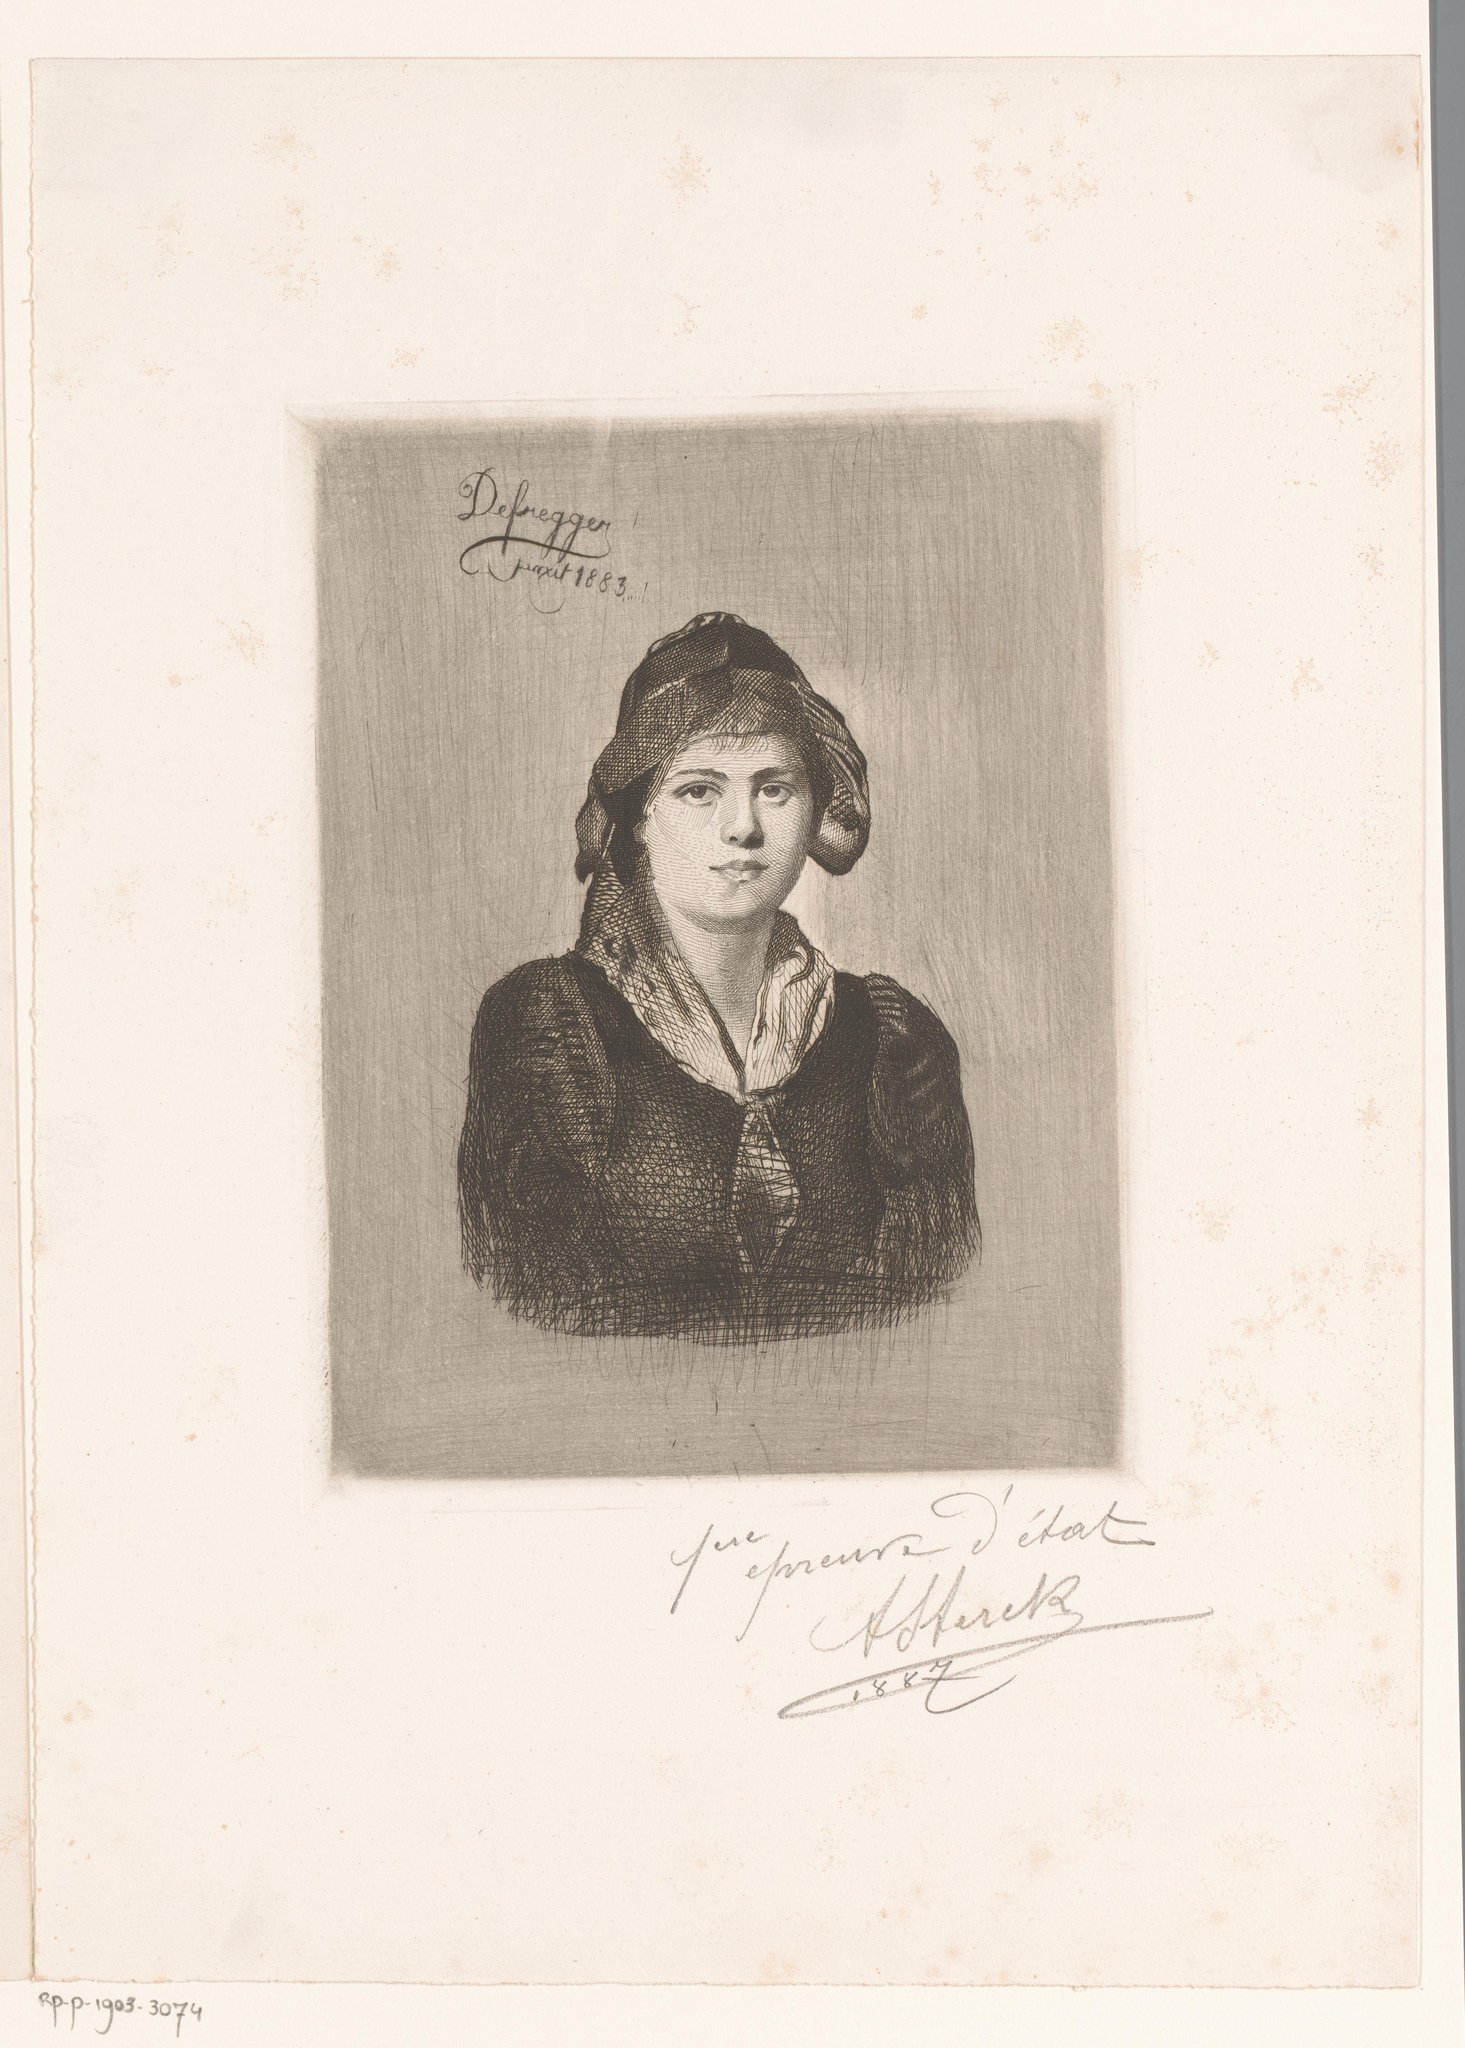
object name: print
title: Jonge vrouw met kanten hoofddeksel en sjaal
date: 1887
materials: paper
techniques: drypoint, etching, intaglio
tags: adolescent, young woman, maiden, head-gear (with name)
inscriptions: collector's mark: Lugt 2228, annotation: ‘1ere epreuve d'état’